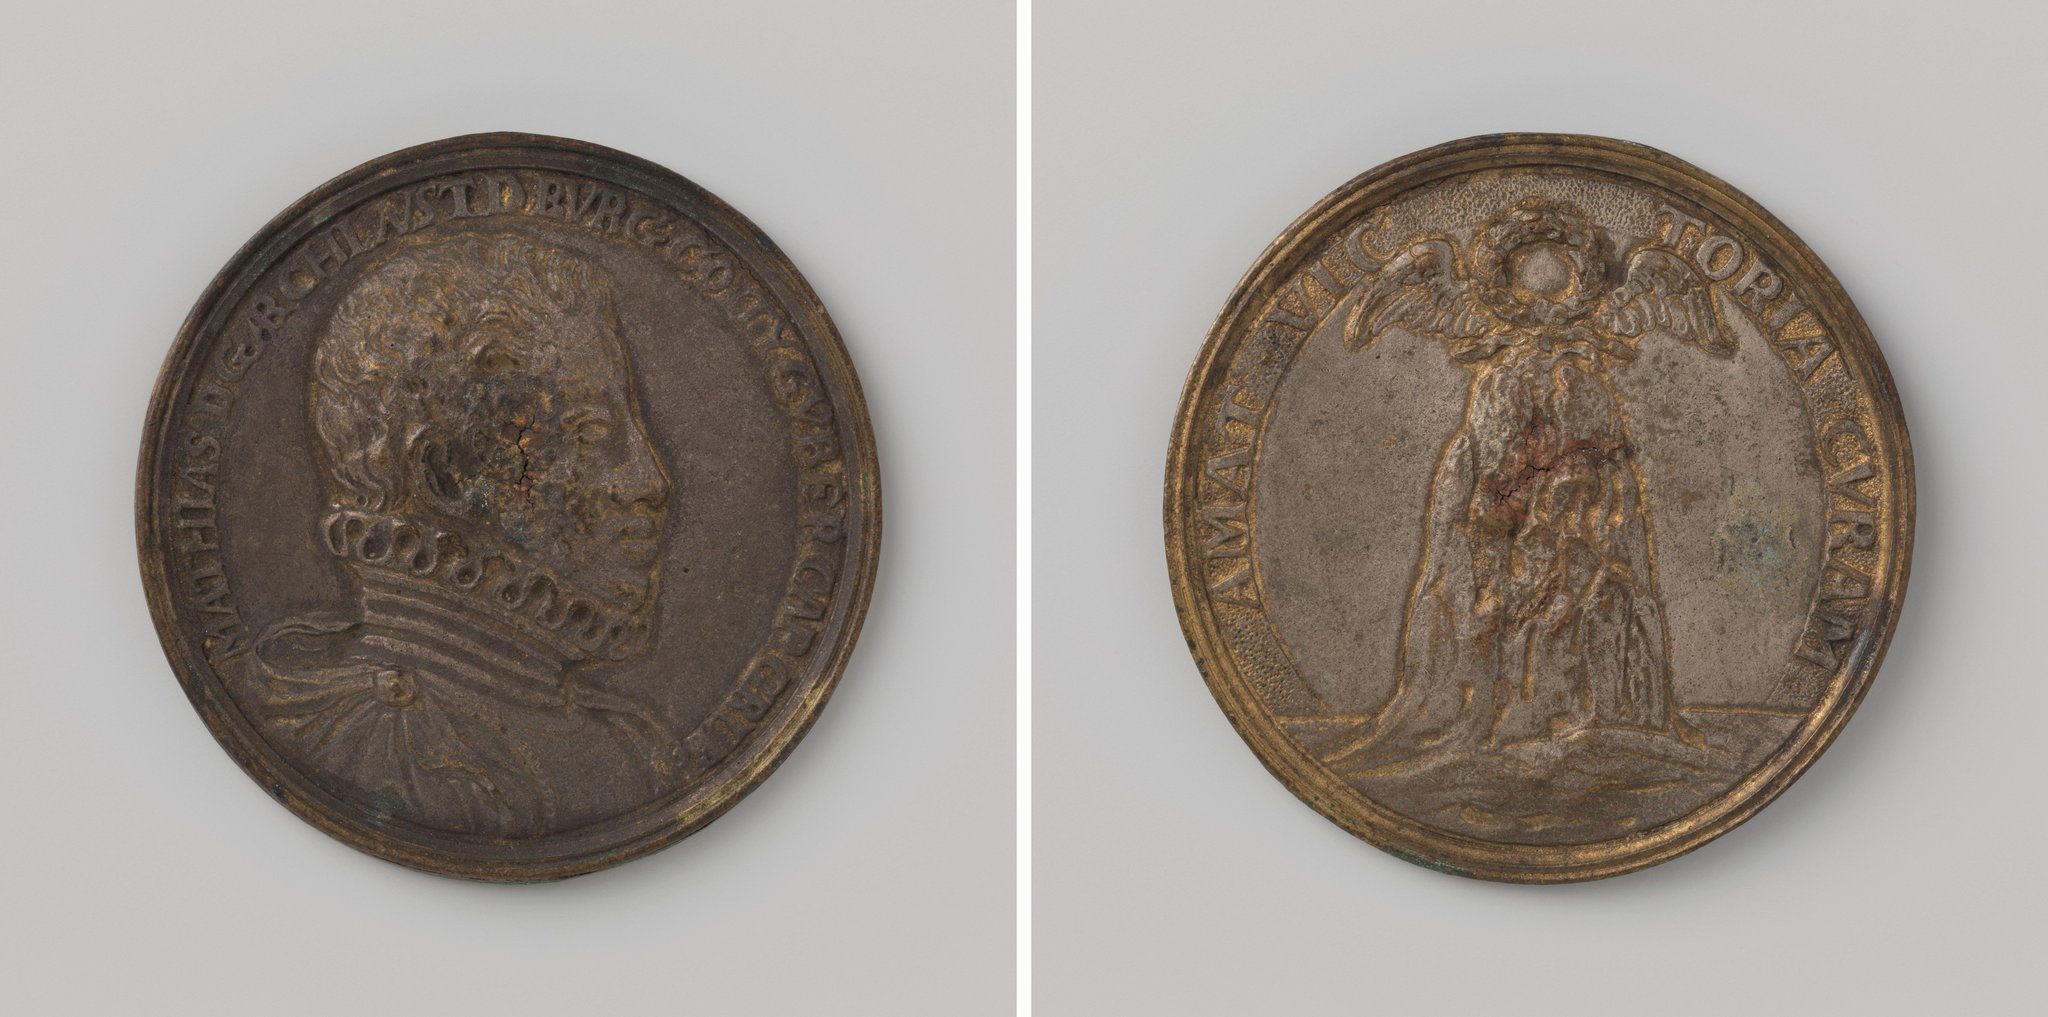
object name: copy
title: Matthias, aartshertog van Oostenrijk, landvoogd der Nederlanden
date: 1579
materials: bronze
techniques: striking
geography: rome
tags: vienna, matthias van oostenrijk (rooms-duits keizer)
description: Bronzen penning. Voorzijde: borststuk man binnen omschrift. Keerzijde: gevleugelde lauwerkrans op steile berg binnen omschrift